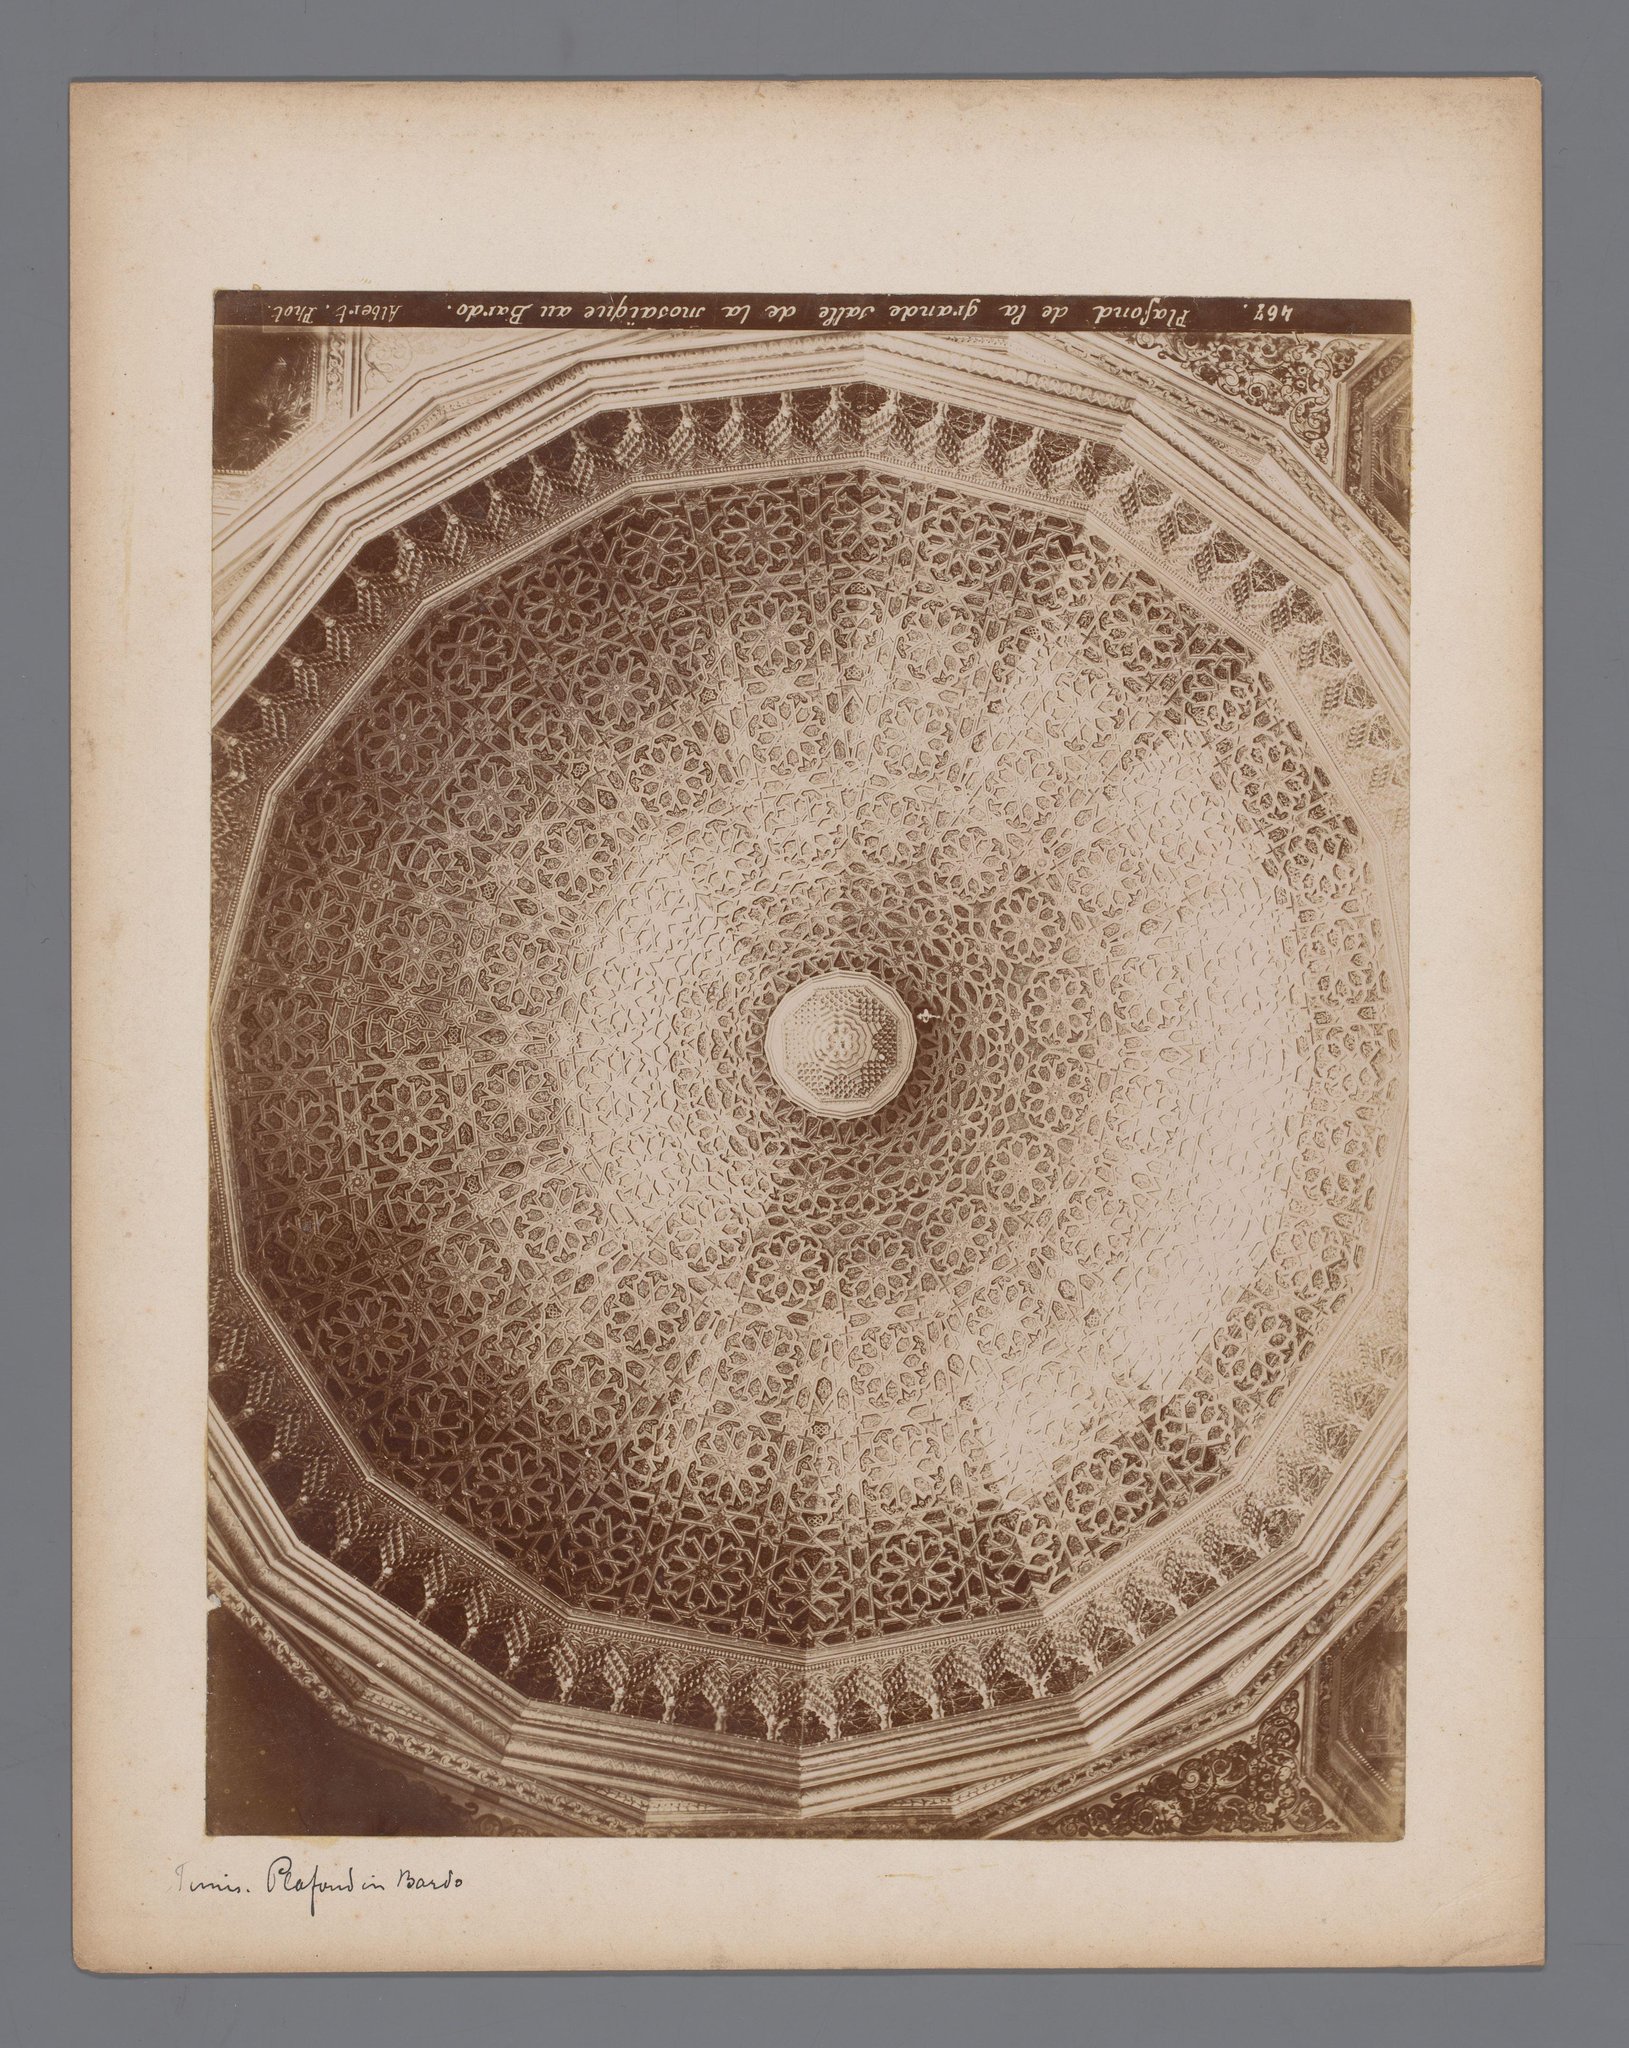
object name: photograph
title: Plafond in het Bardomuseum in Le Bardo nabij Tunis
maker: albert goupil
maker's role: publisher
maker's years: 1840-1884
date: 1888-1905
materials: cardboard, paper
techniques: albumen print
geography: le bardo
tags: (decorated) ceiling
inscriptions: number: ‘467.’